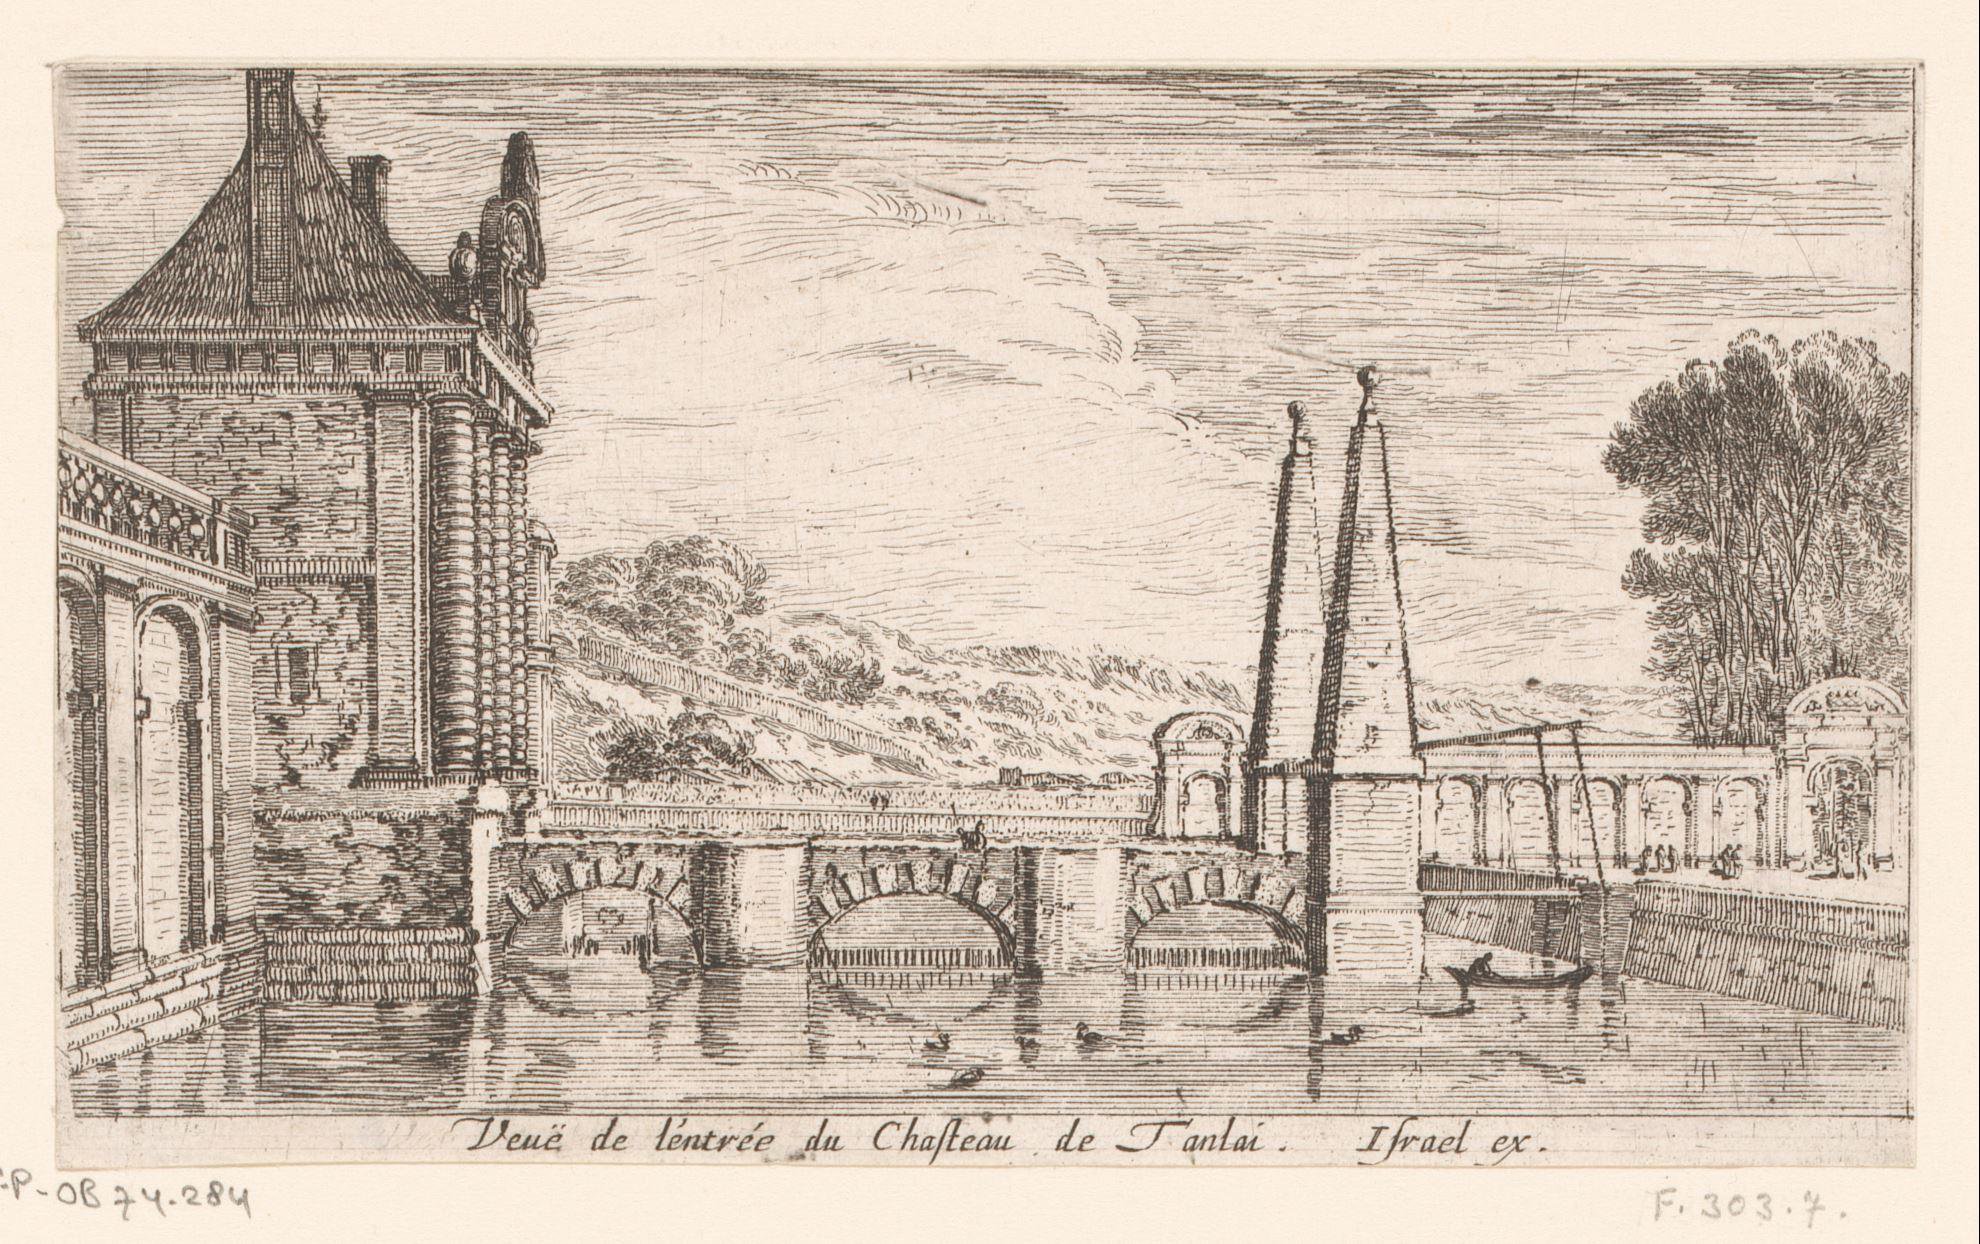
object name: print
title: Veue de l'entrée du Chasteau de Tanlai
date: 1631-1661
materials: paper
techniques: etching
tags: city-view, and landscape with man-made constructions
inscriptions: collector's mark: Lugt 240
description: Prent maakt deel uit van een ongenummerde serie van negen prenten.